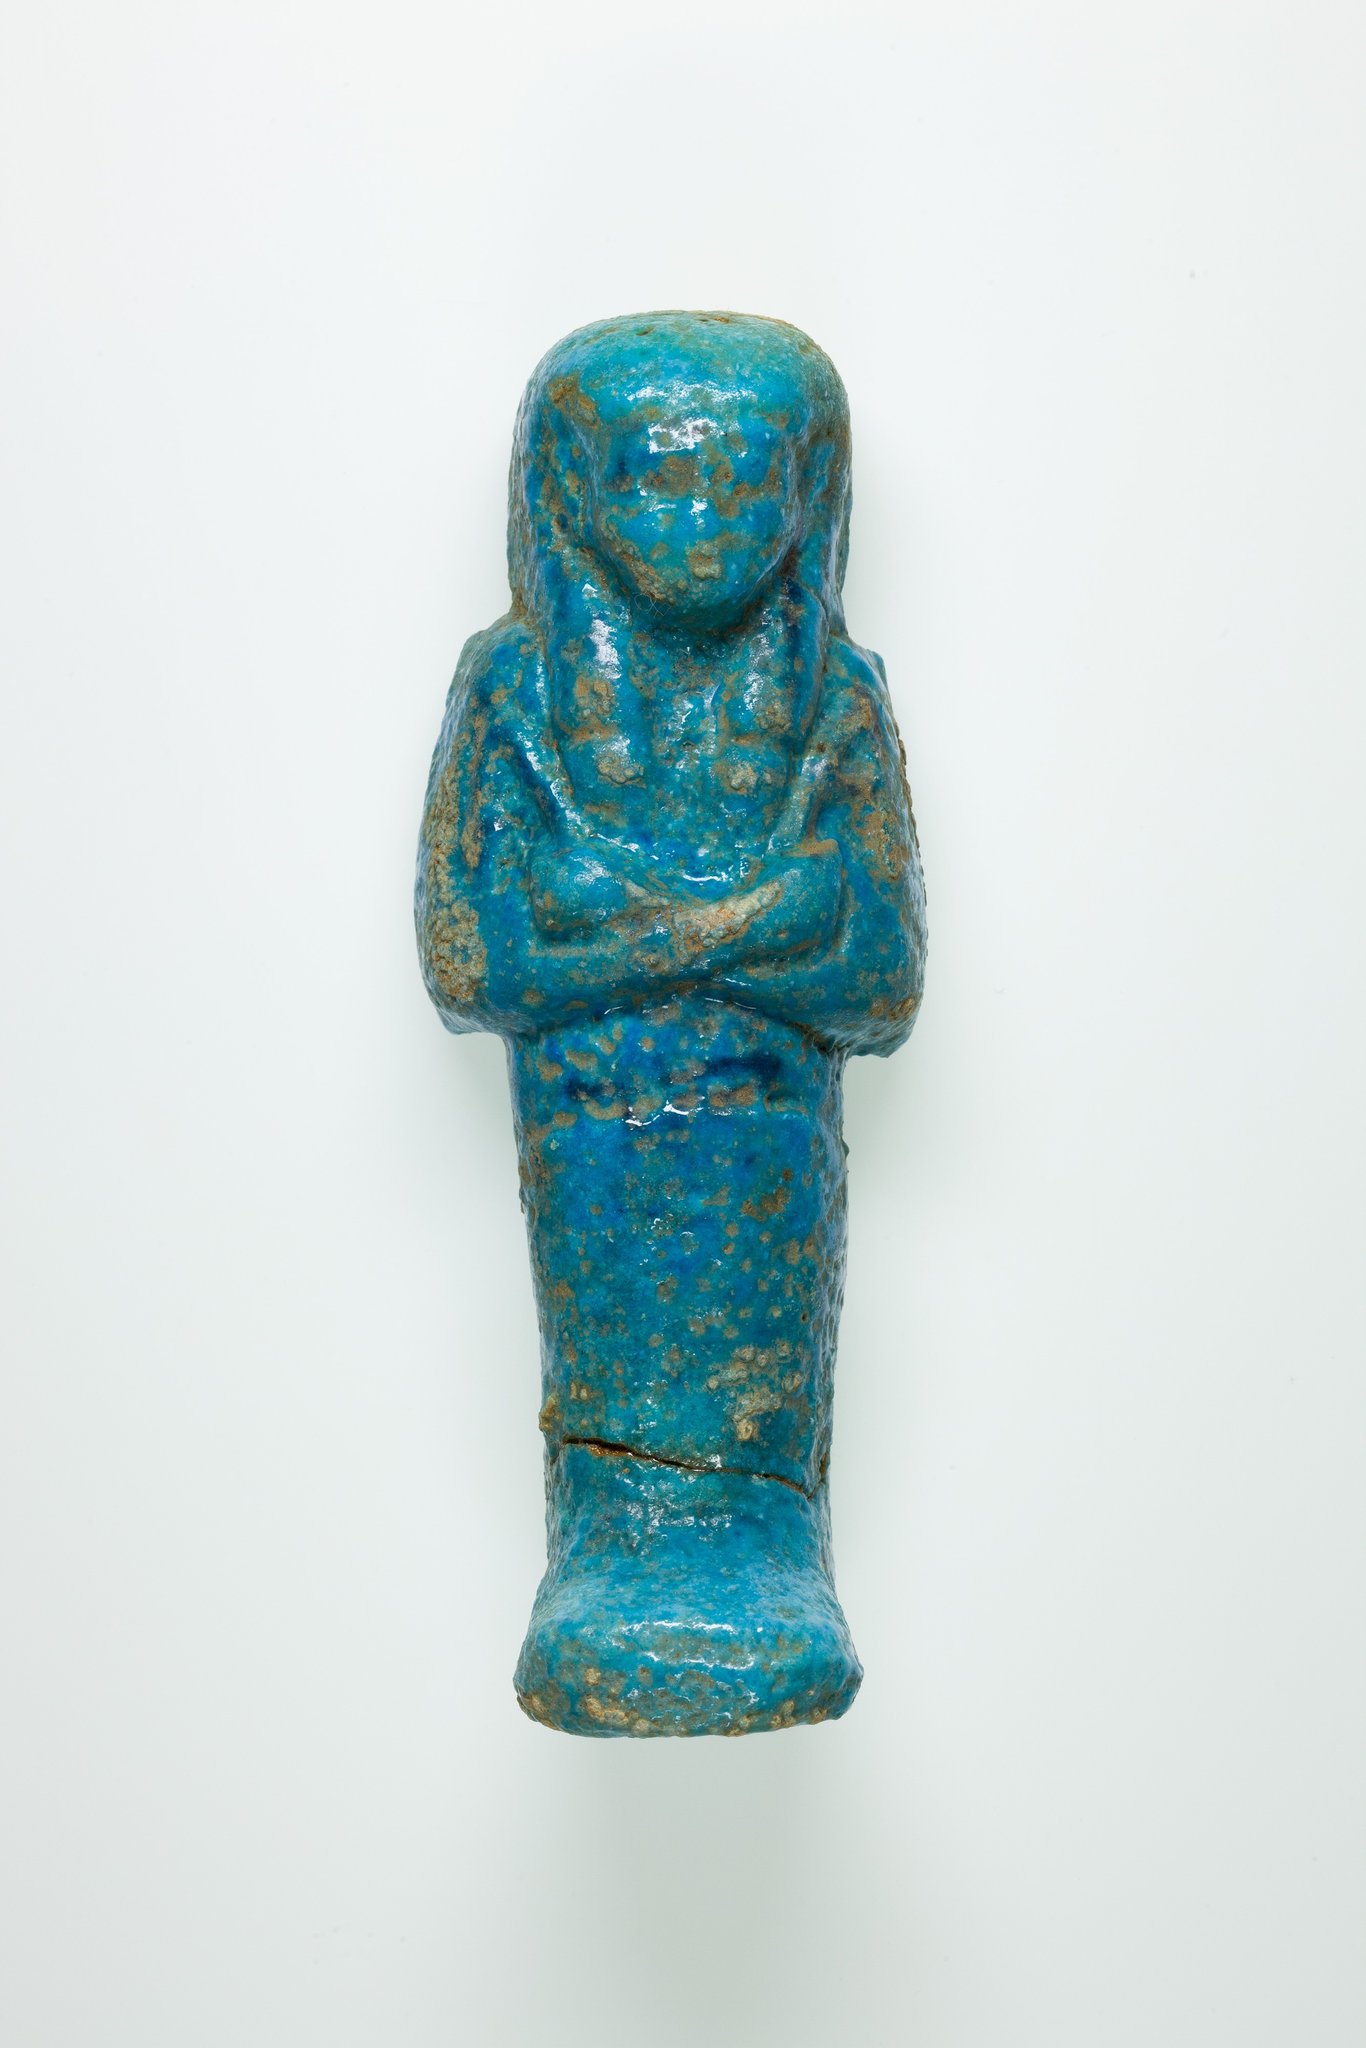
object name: worker shabti, henettawy c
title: Worker Shabti of Henettawy (C), Daughter of Isetemkheb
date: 990-970 BCE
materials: faience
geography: egypt